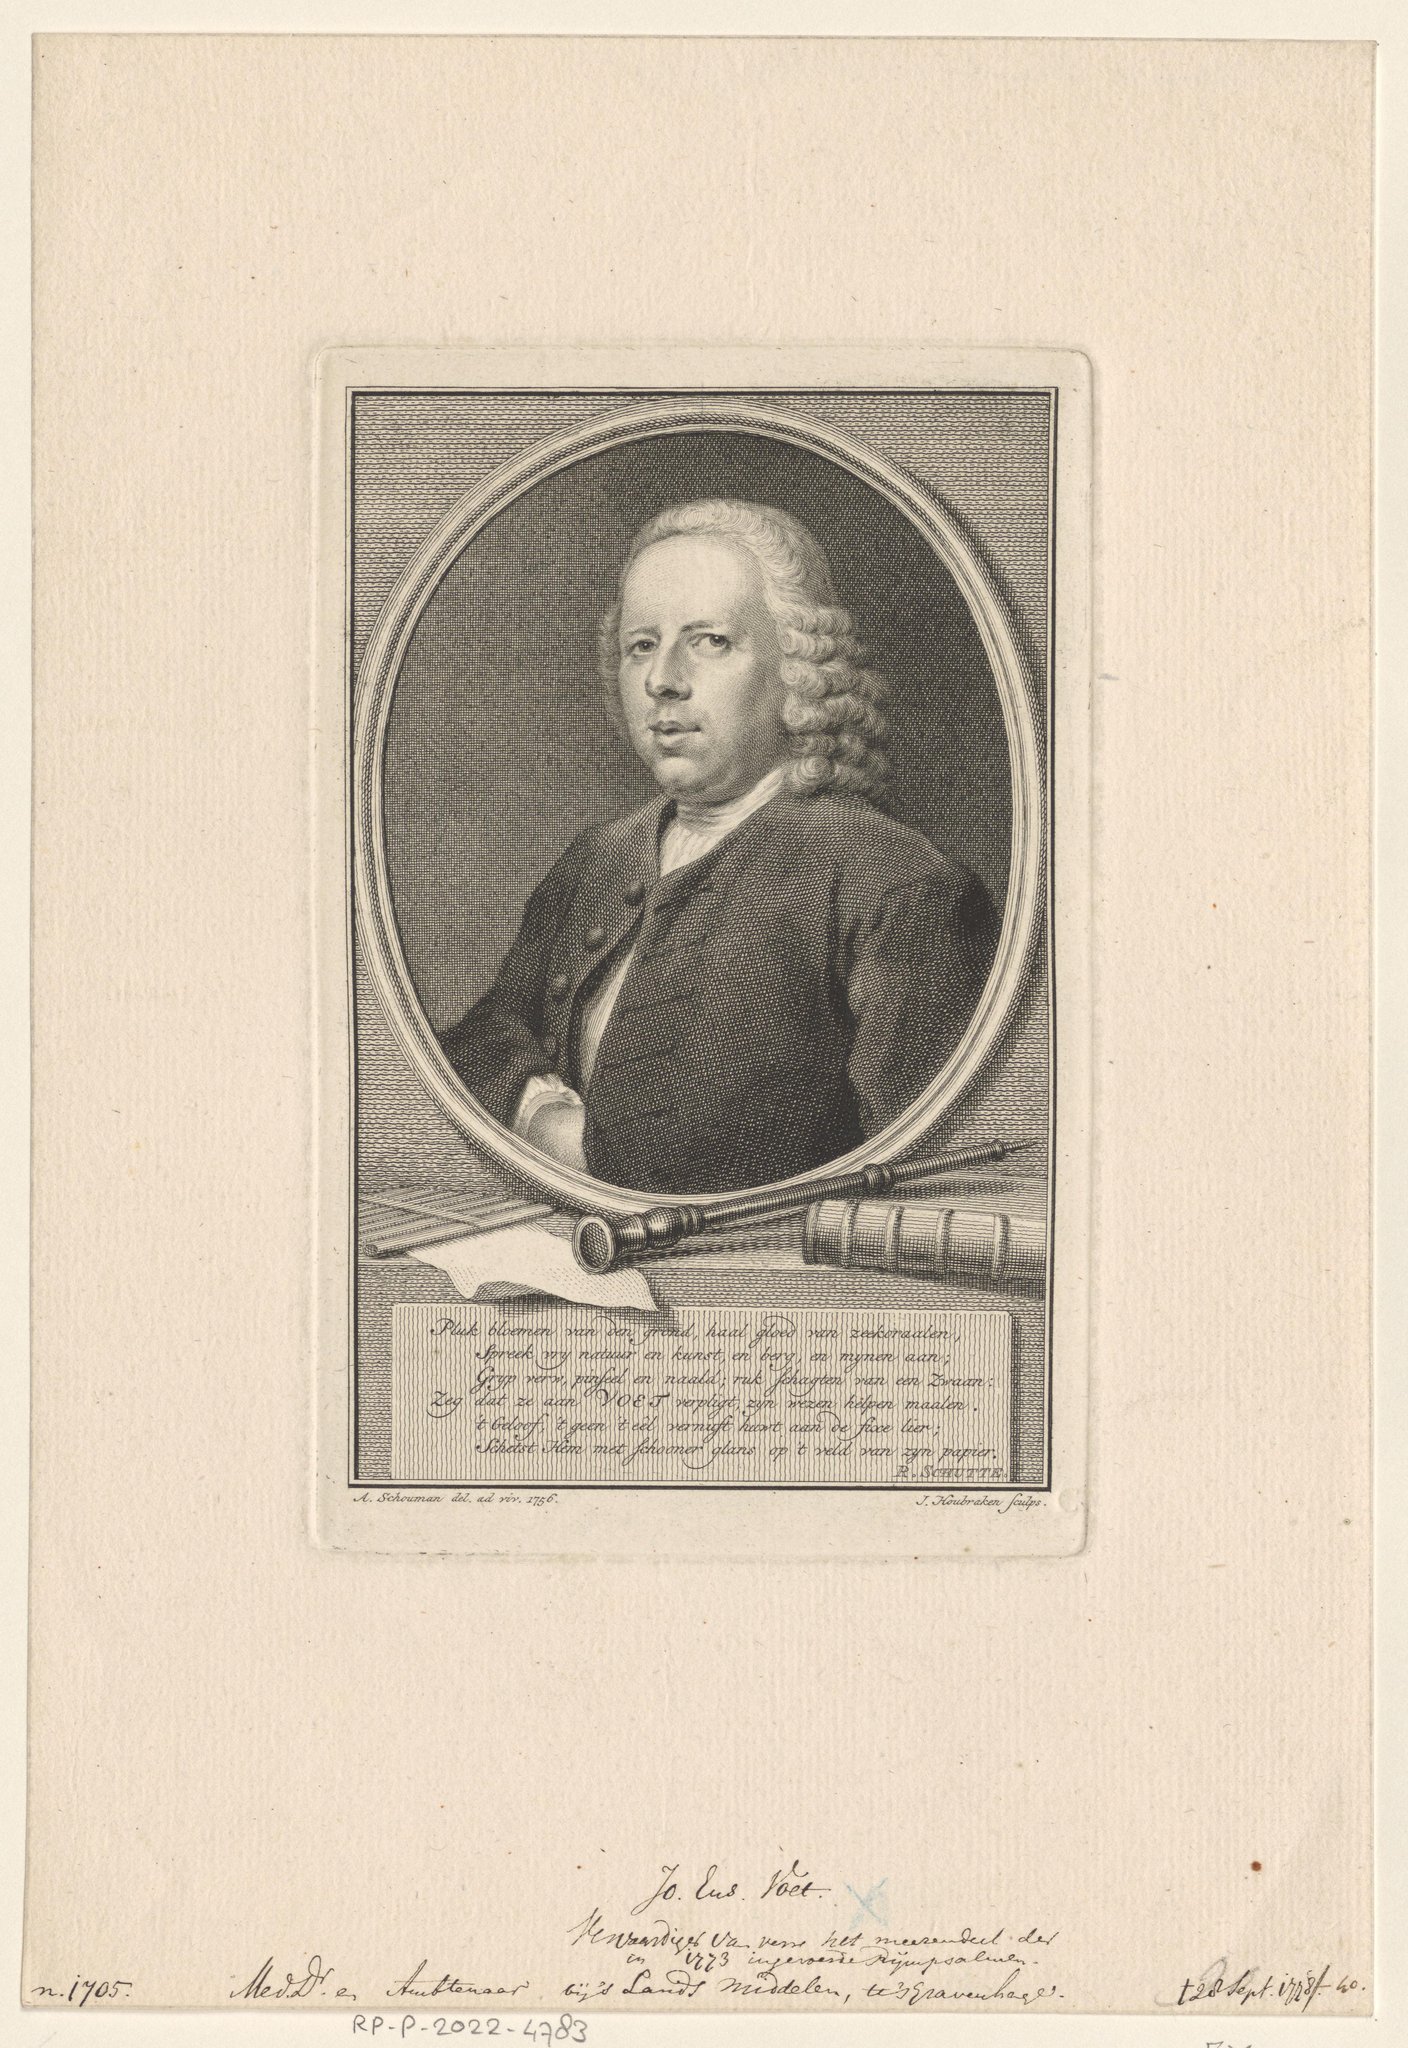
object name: print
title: Portret van Johannes Eusebius Voet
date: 1756-1780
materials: paper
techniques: engraving, etching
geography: amsterdam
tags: dordrecht, johannes eusebius voet, historical persons, portrait of a writer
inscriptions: collector's mark: Lugt 2228, collector's mark: Lugt 1120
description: Met zesregelig onderschrift in het Nederlands.